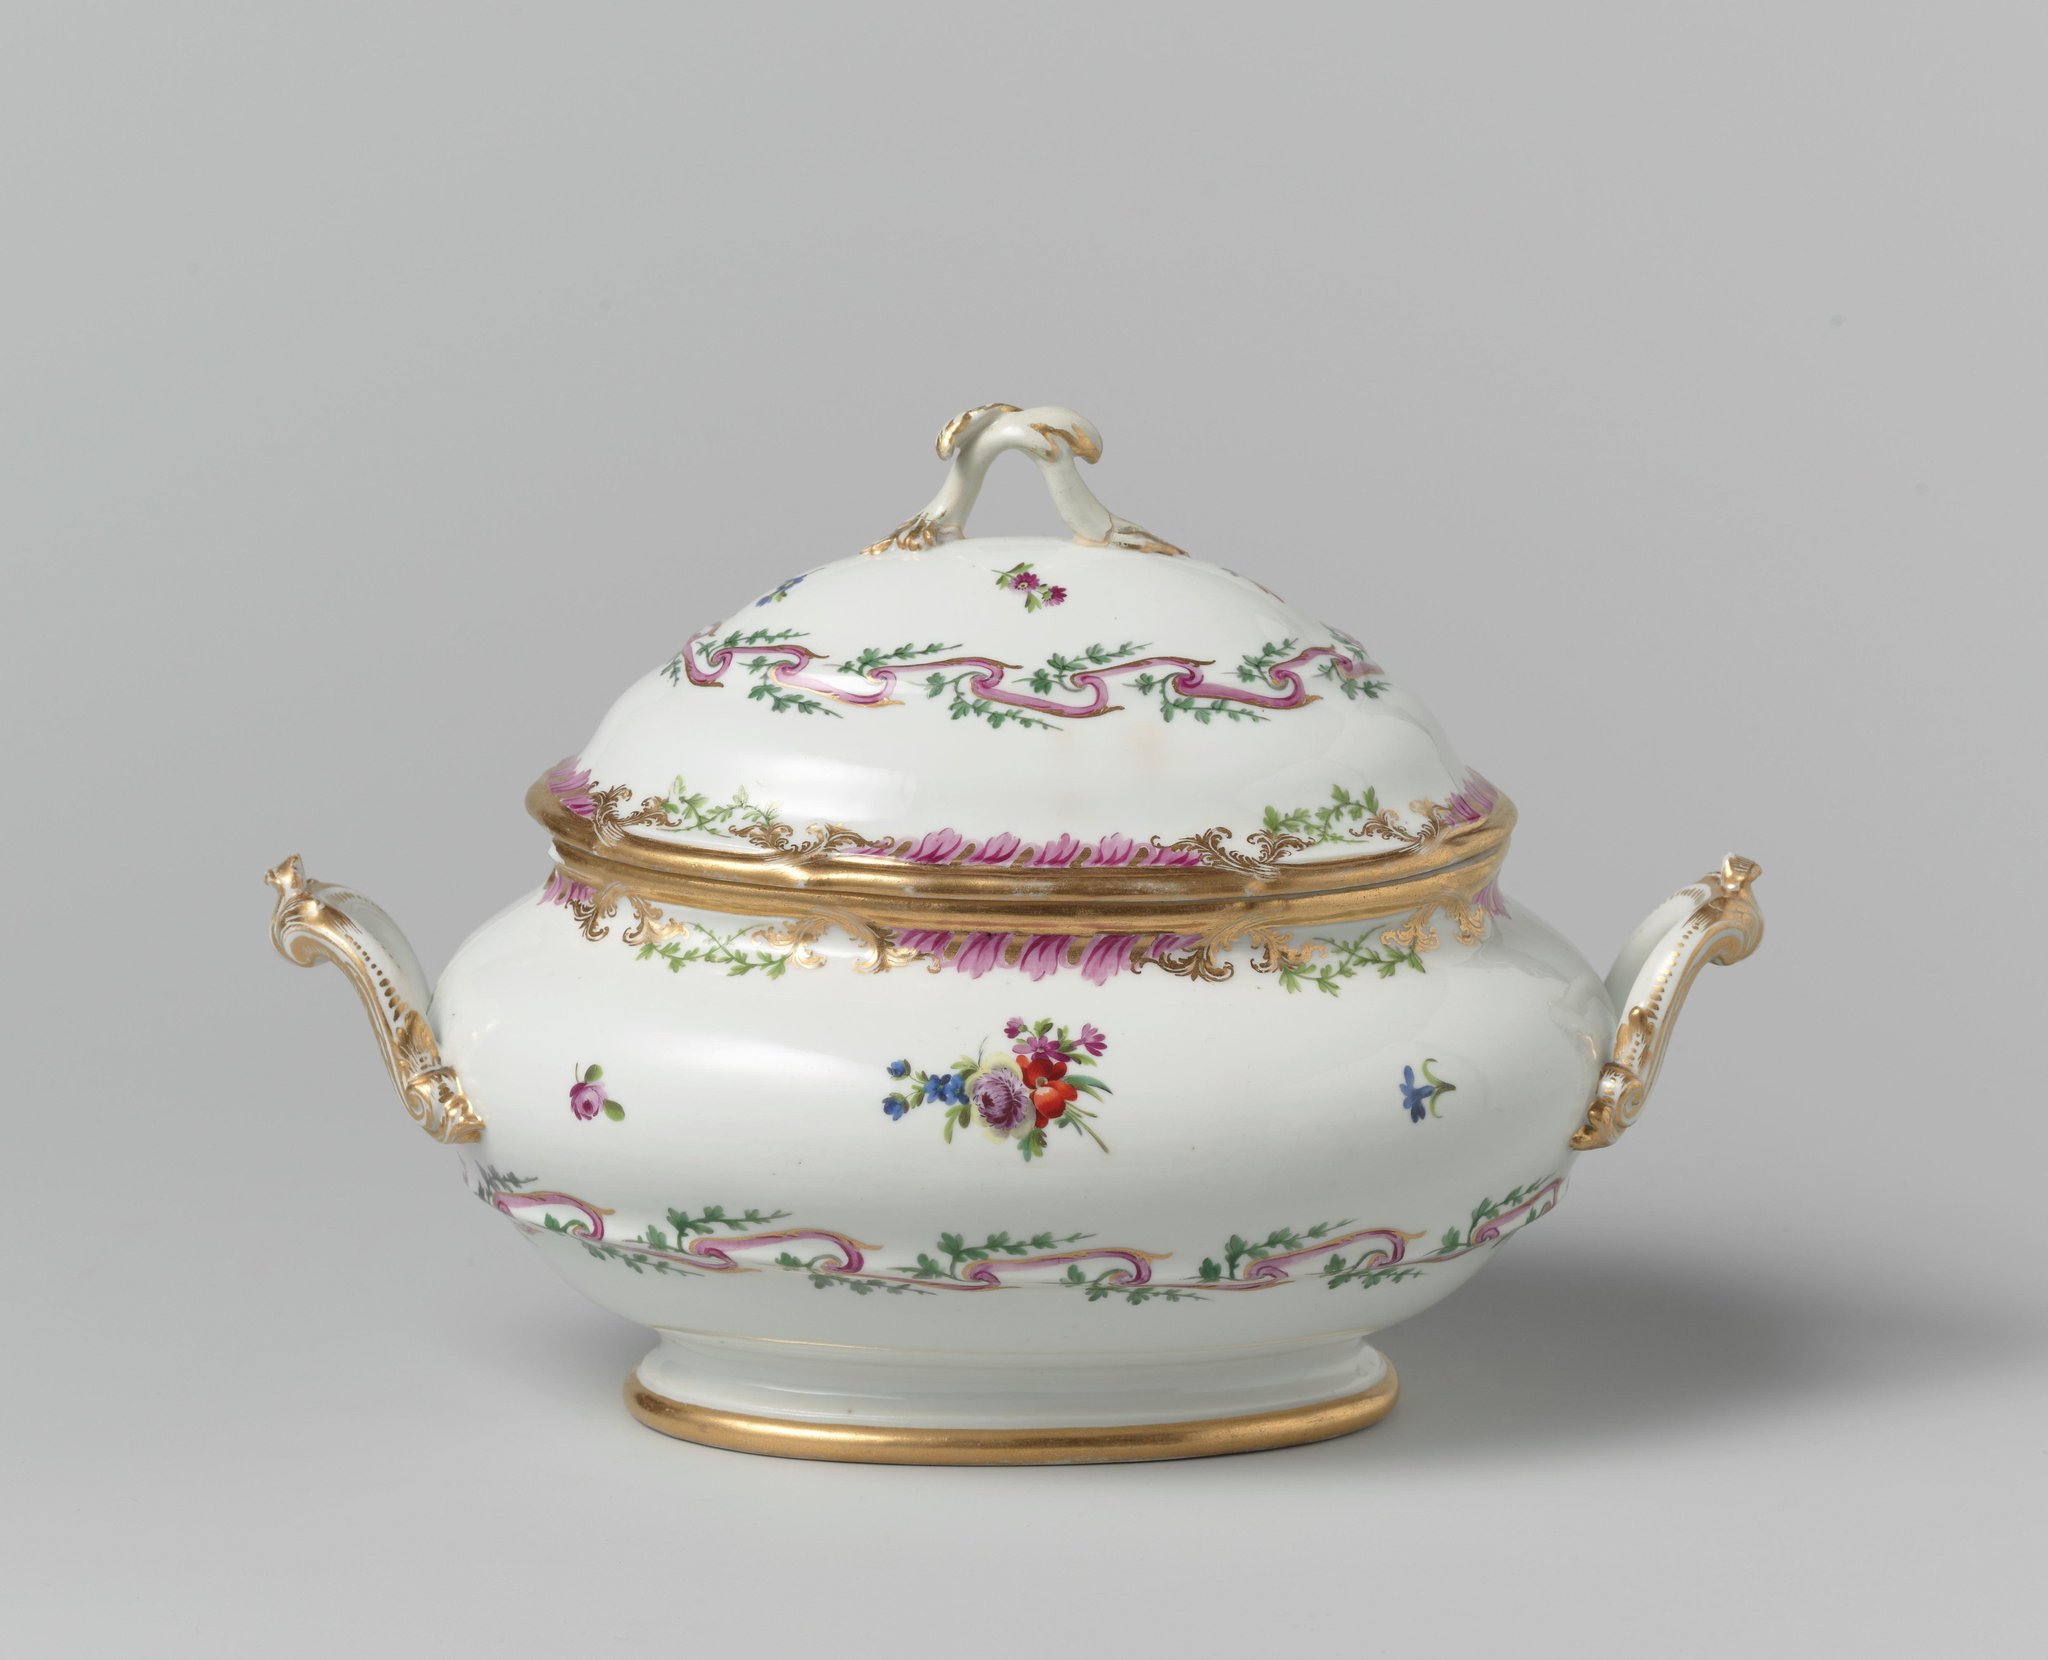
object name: sauce tureen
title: Sauceboat, cream pots and plate, part of a service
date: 1784-1809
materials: porcelain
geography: ouder-amstel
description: Porceleinfabriek aan den Amstel Manufactuur Oud-Loosdrecht Ouder-Amstel and Loosdrecht, c. 1784-1809 hard-paste porcelain